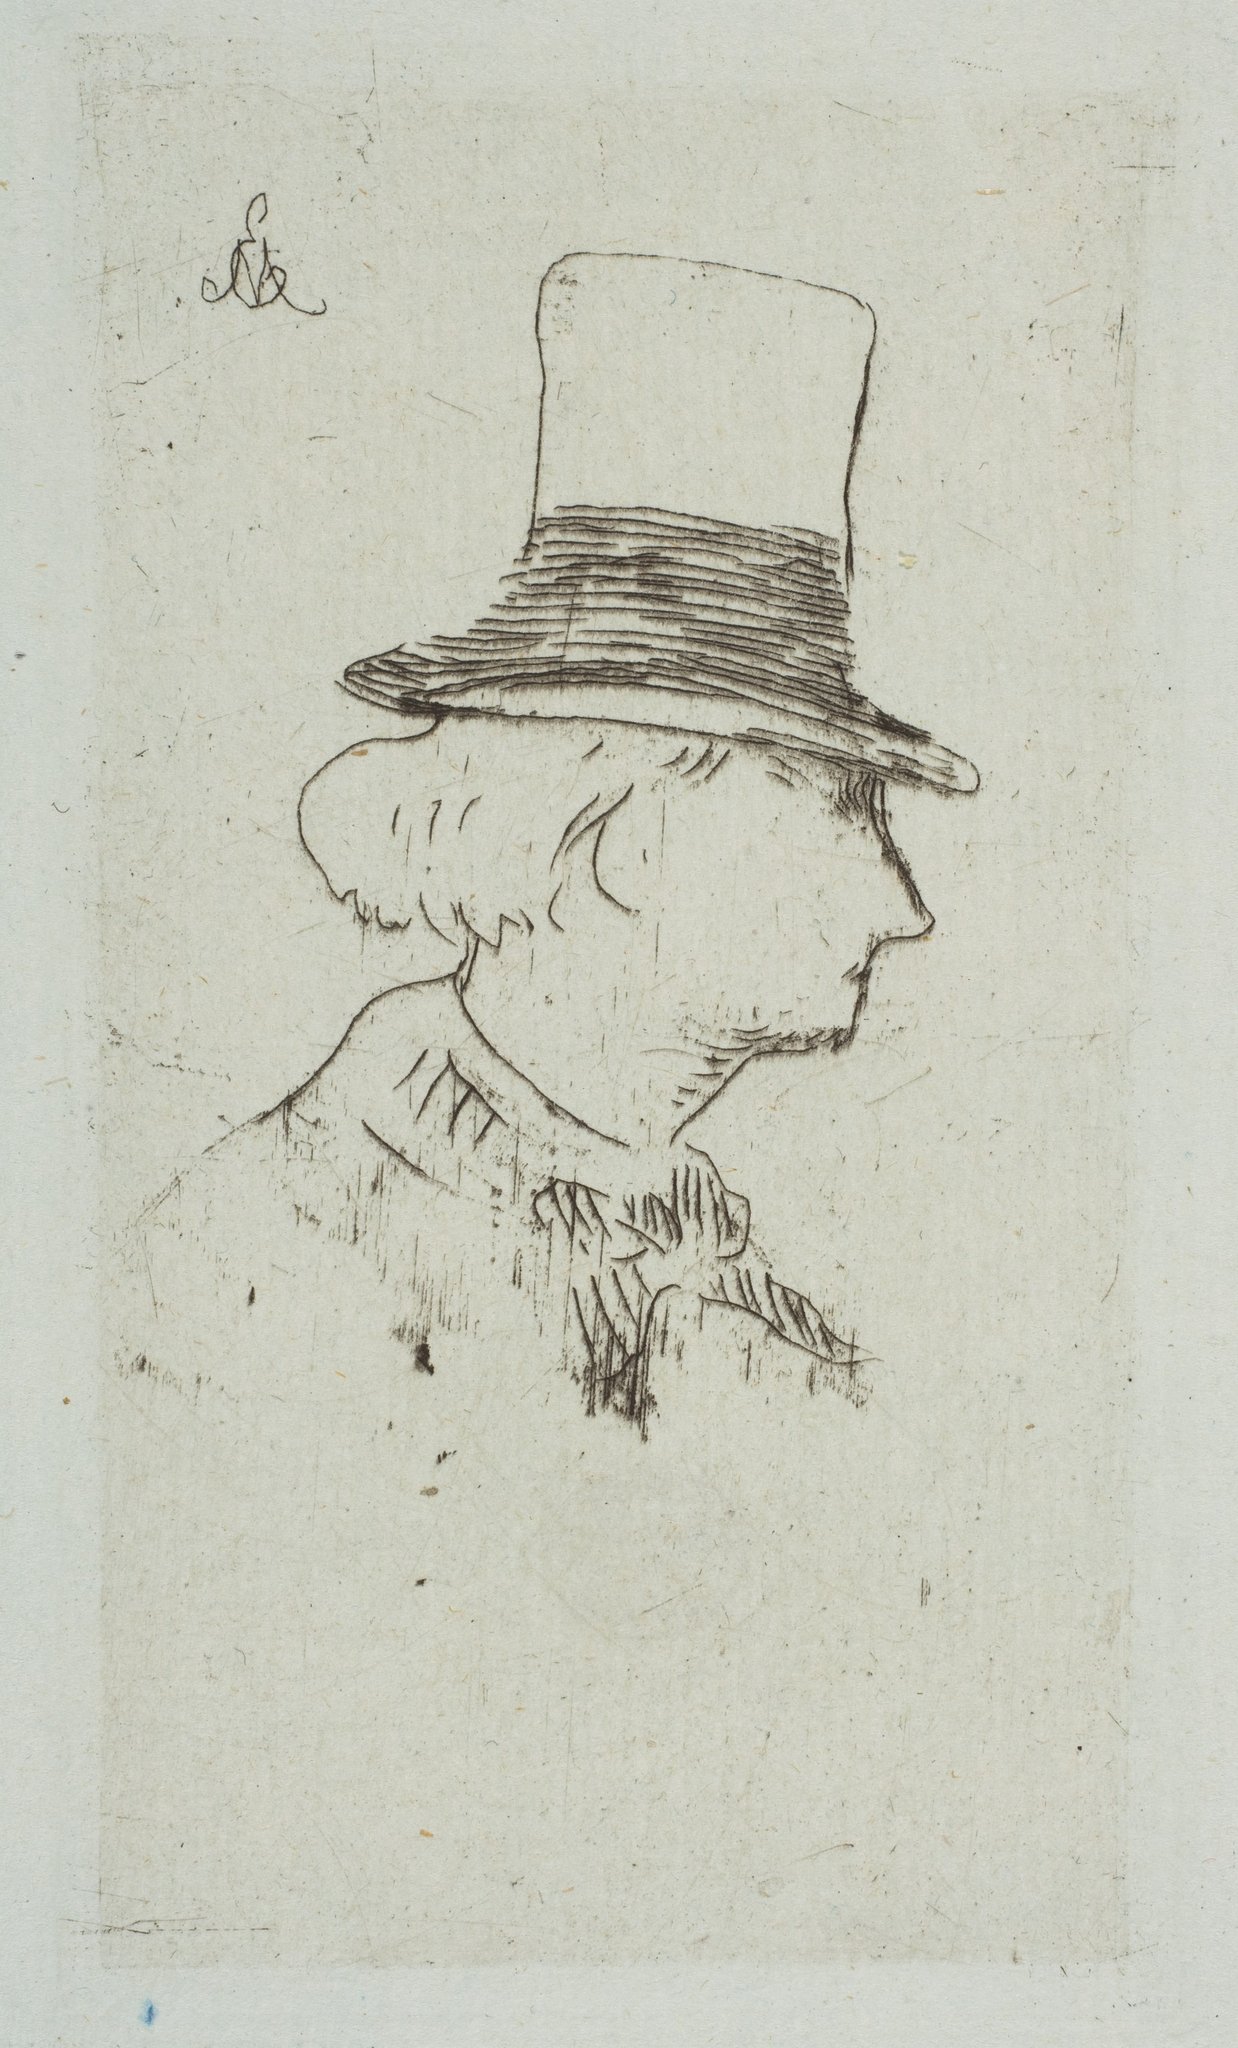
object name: print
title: Portrait of Charles Baudelaire in Profile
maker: édouard manet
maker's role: artist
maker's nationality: french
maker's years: 1832-1883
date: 1862-1867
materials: paper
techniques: etching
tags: hats,men,profiles